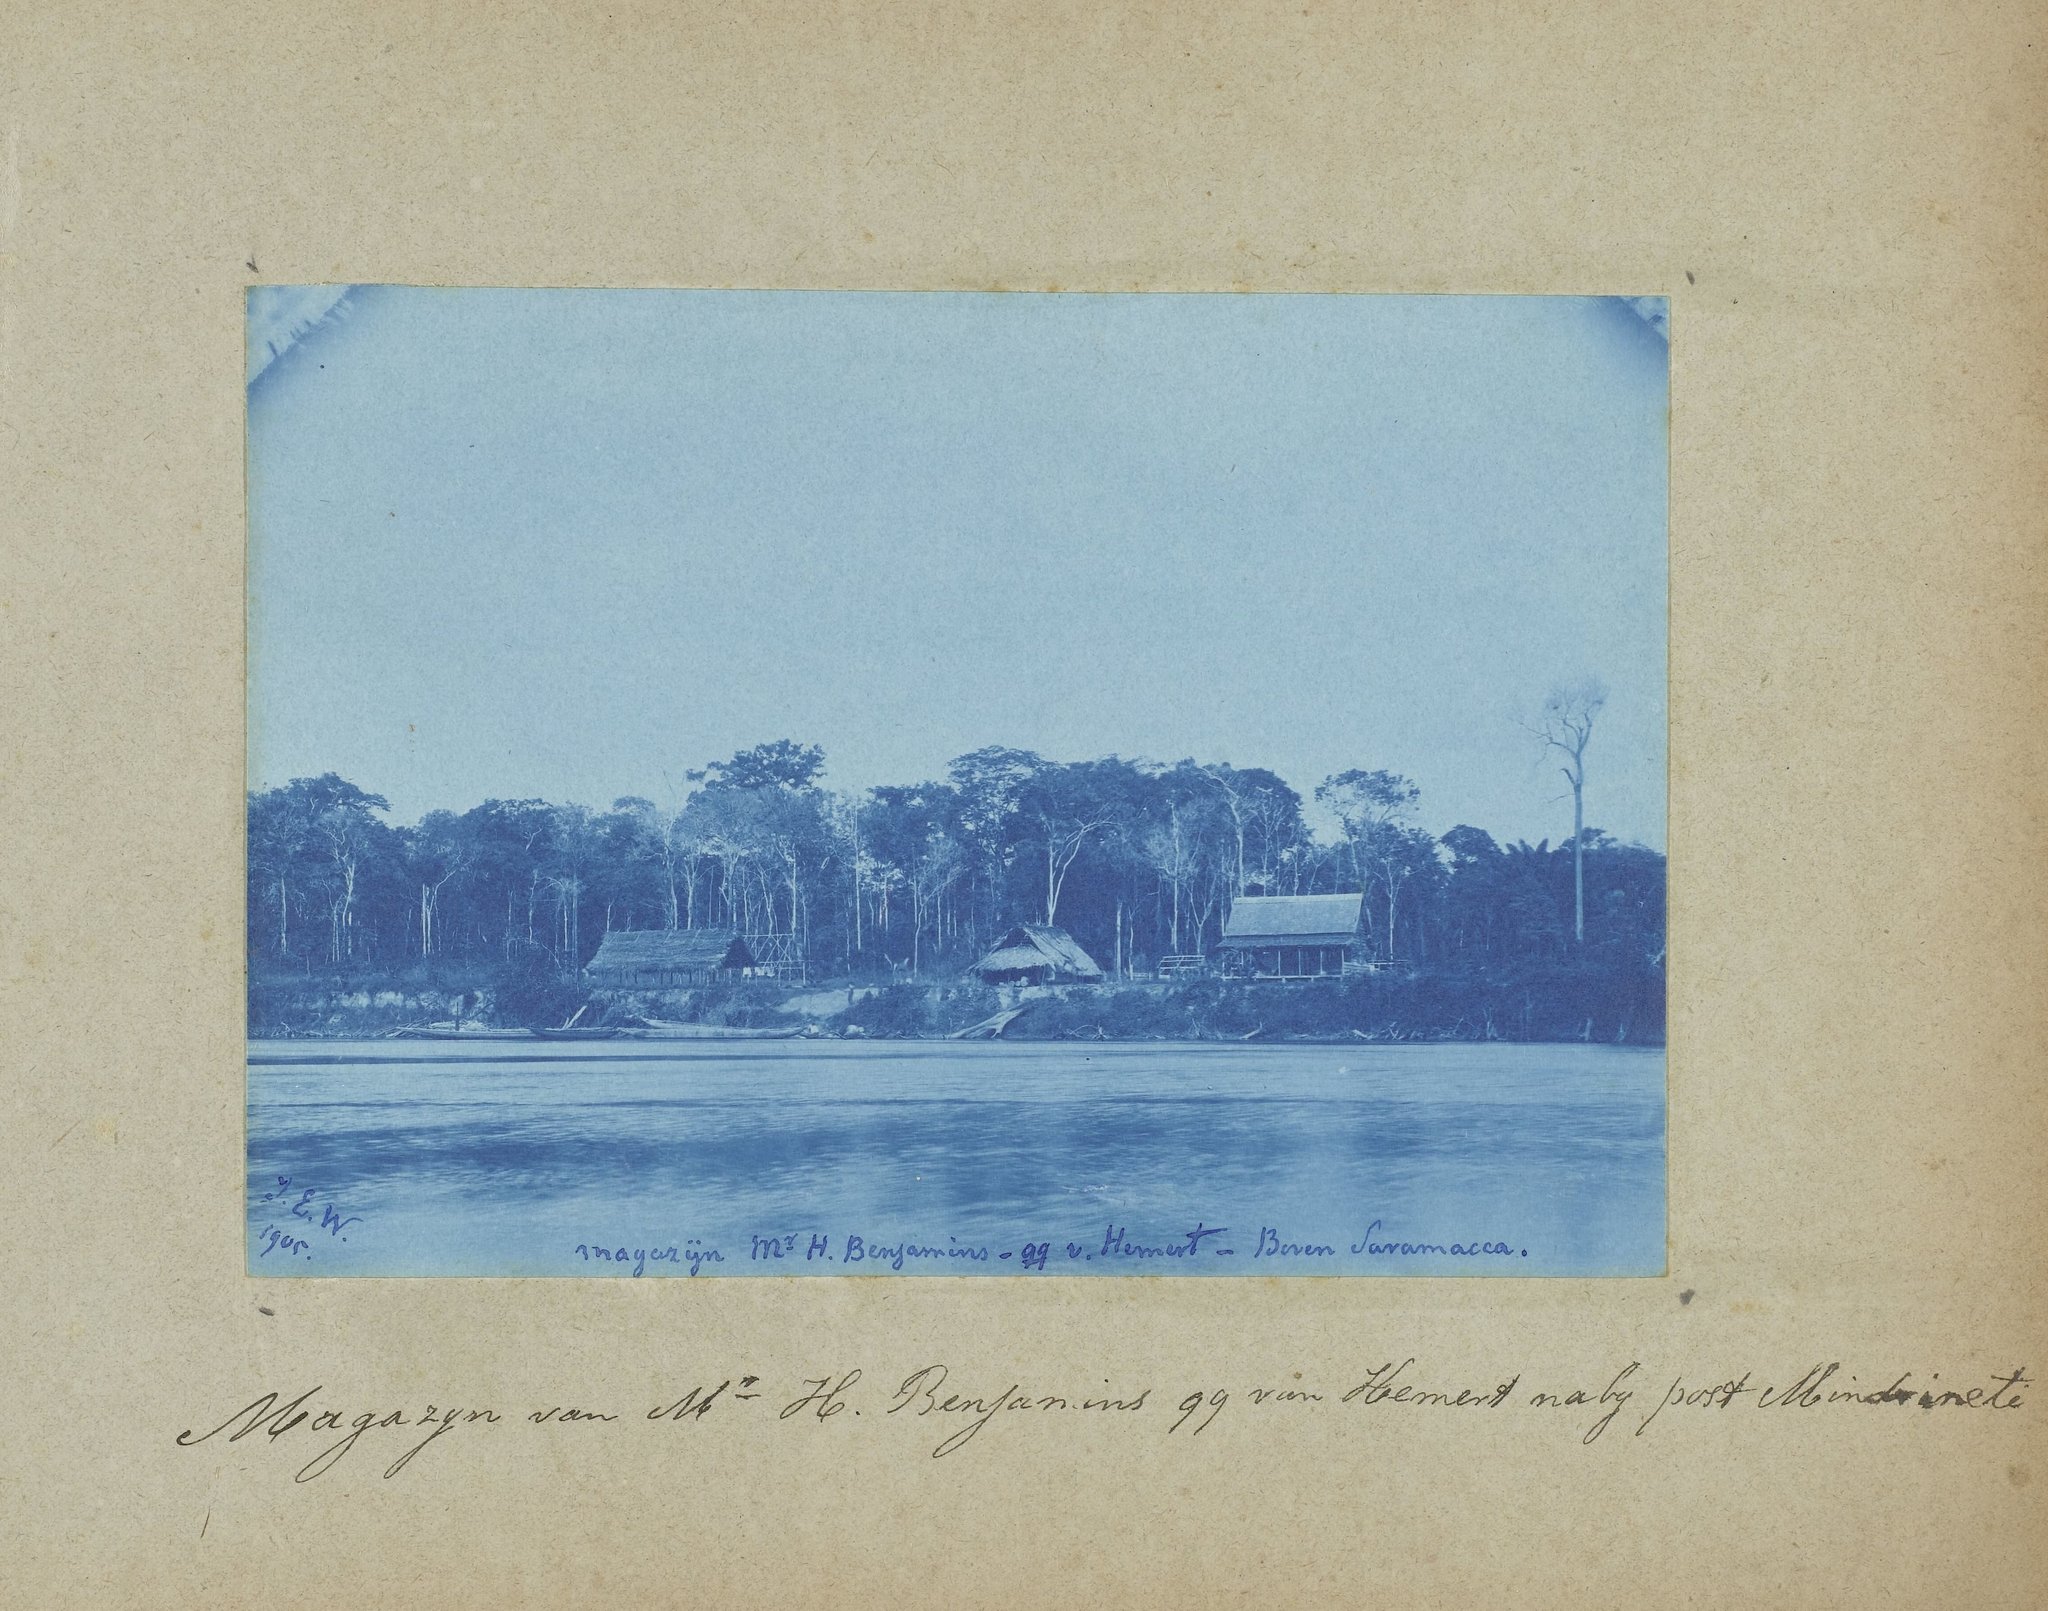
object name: photograph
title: Magazijn van Mr. H. Benjamins 99 van Hemert nabij post Mindrineti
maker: jacob evert wesenhagen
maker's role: amateurfotograaf, arts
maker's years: 1862-1924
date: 1905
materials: photographic support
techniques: cyanotype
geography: suriname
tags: jacob evert wesenhagen, railway, tramway; rack railway, suriname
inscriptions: inscription: ‘Magazijn van Mr. H. Benjamins 99 van Hemert nabij post Mindrineti’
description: Magazijn van Mr. H. Benjamins nabij post Mindrineti, boven Saramacca. Foto in het fotoalbum over de aanleg van de Lawaspoorweg in Suriname in de jaren 1903-1912. Onderdeel van een groep objecten afkomstig van de familie Wesenhagen in Suriname.